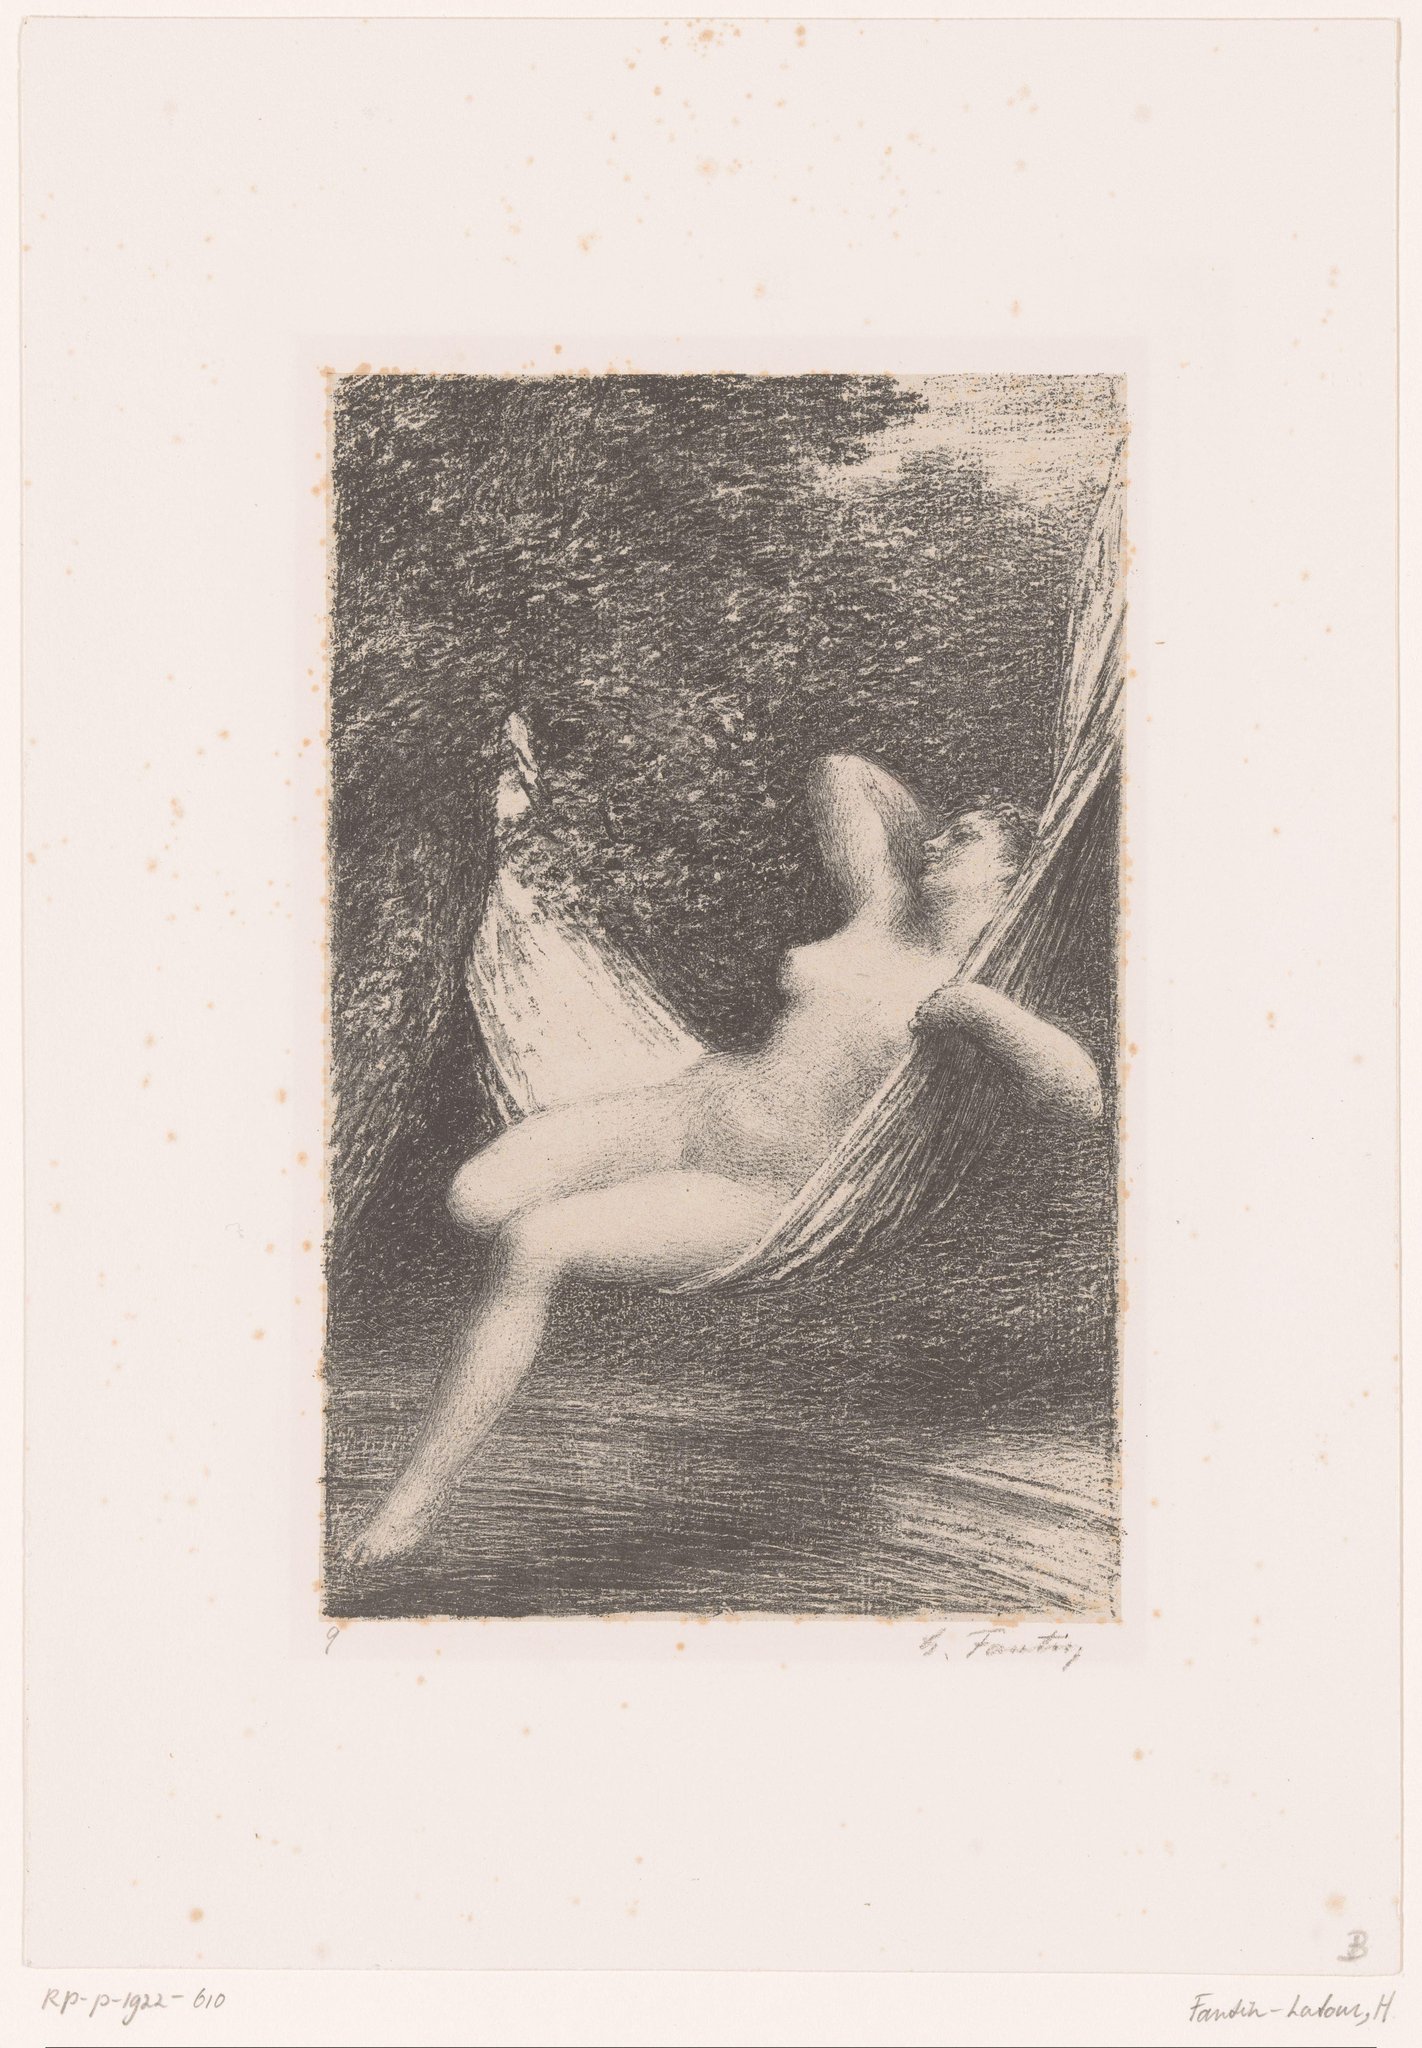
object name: print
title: Sara schommelt naakt in een hangmat boven het water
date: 1888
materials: paper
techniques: lithography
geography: paris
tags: hammock, 'après le bain' - aa - in the open air, woman (showing herself) undressed, quasi-nude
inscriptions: collector's mark: Lugt 2228a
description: Prent gebruikt voor: A. Jullien, Hector Berlioz: sa vie et ses œuvres, Parijs 1888, p. 206-207. Sara la baigneuse is een gedicht van Victor Hugo, waar Berlioz een melodie voor componeerde.